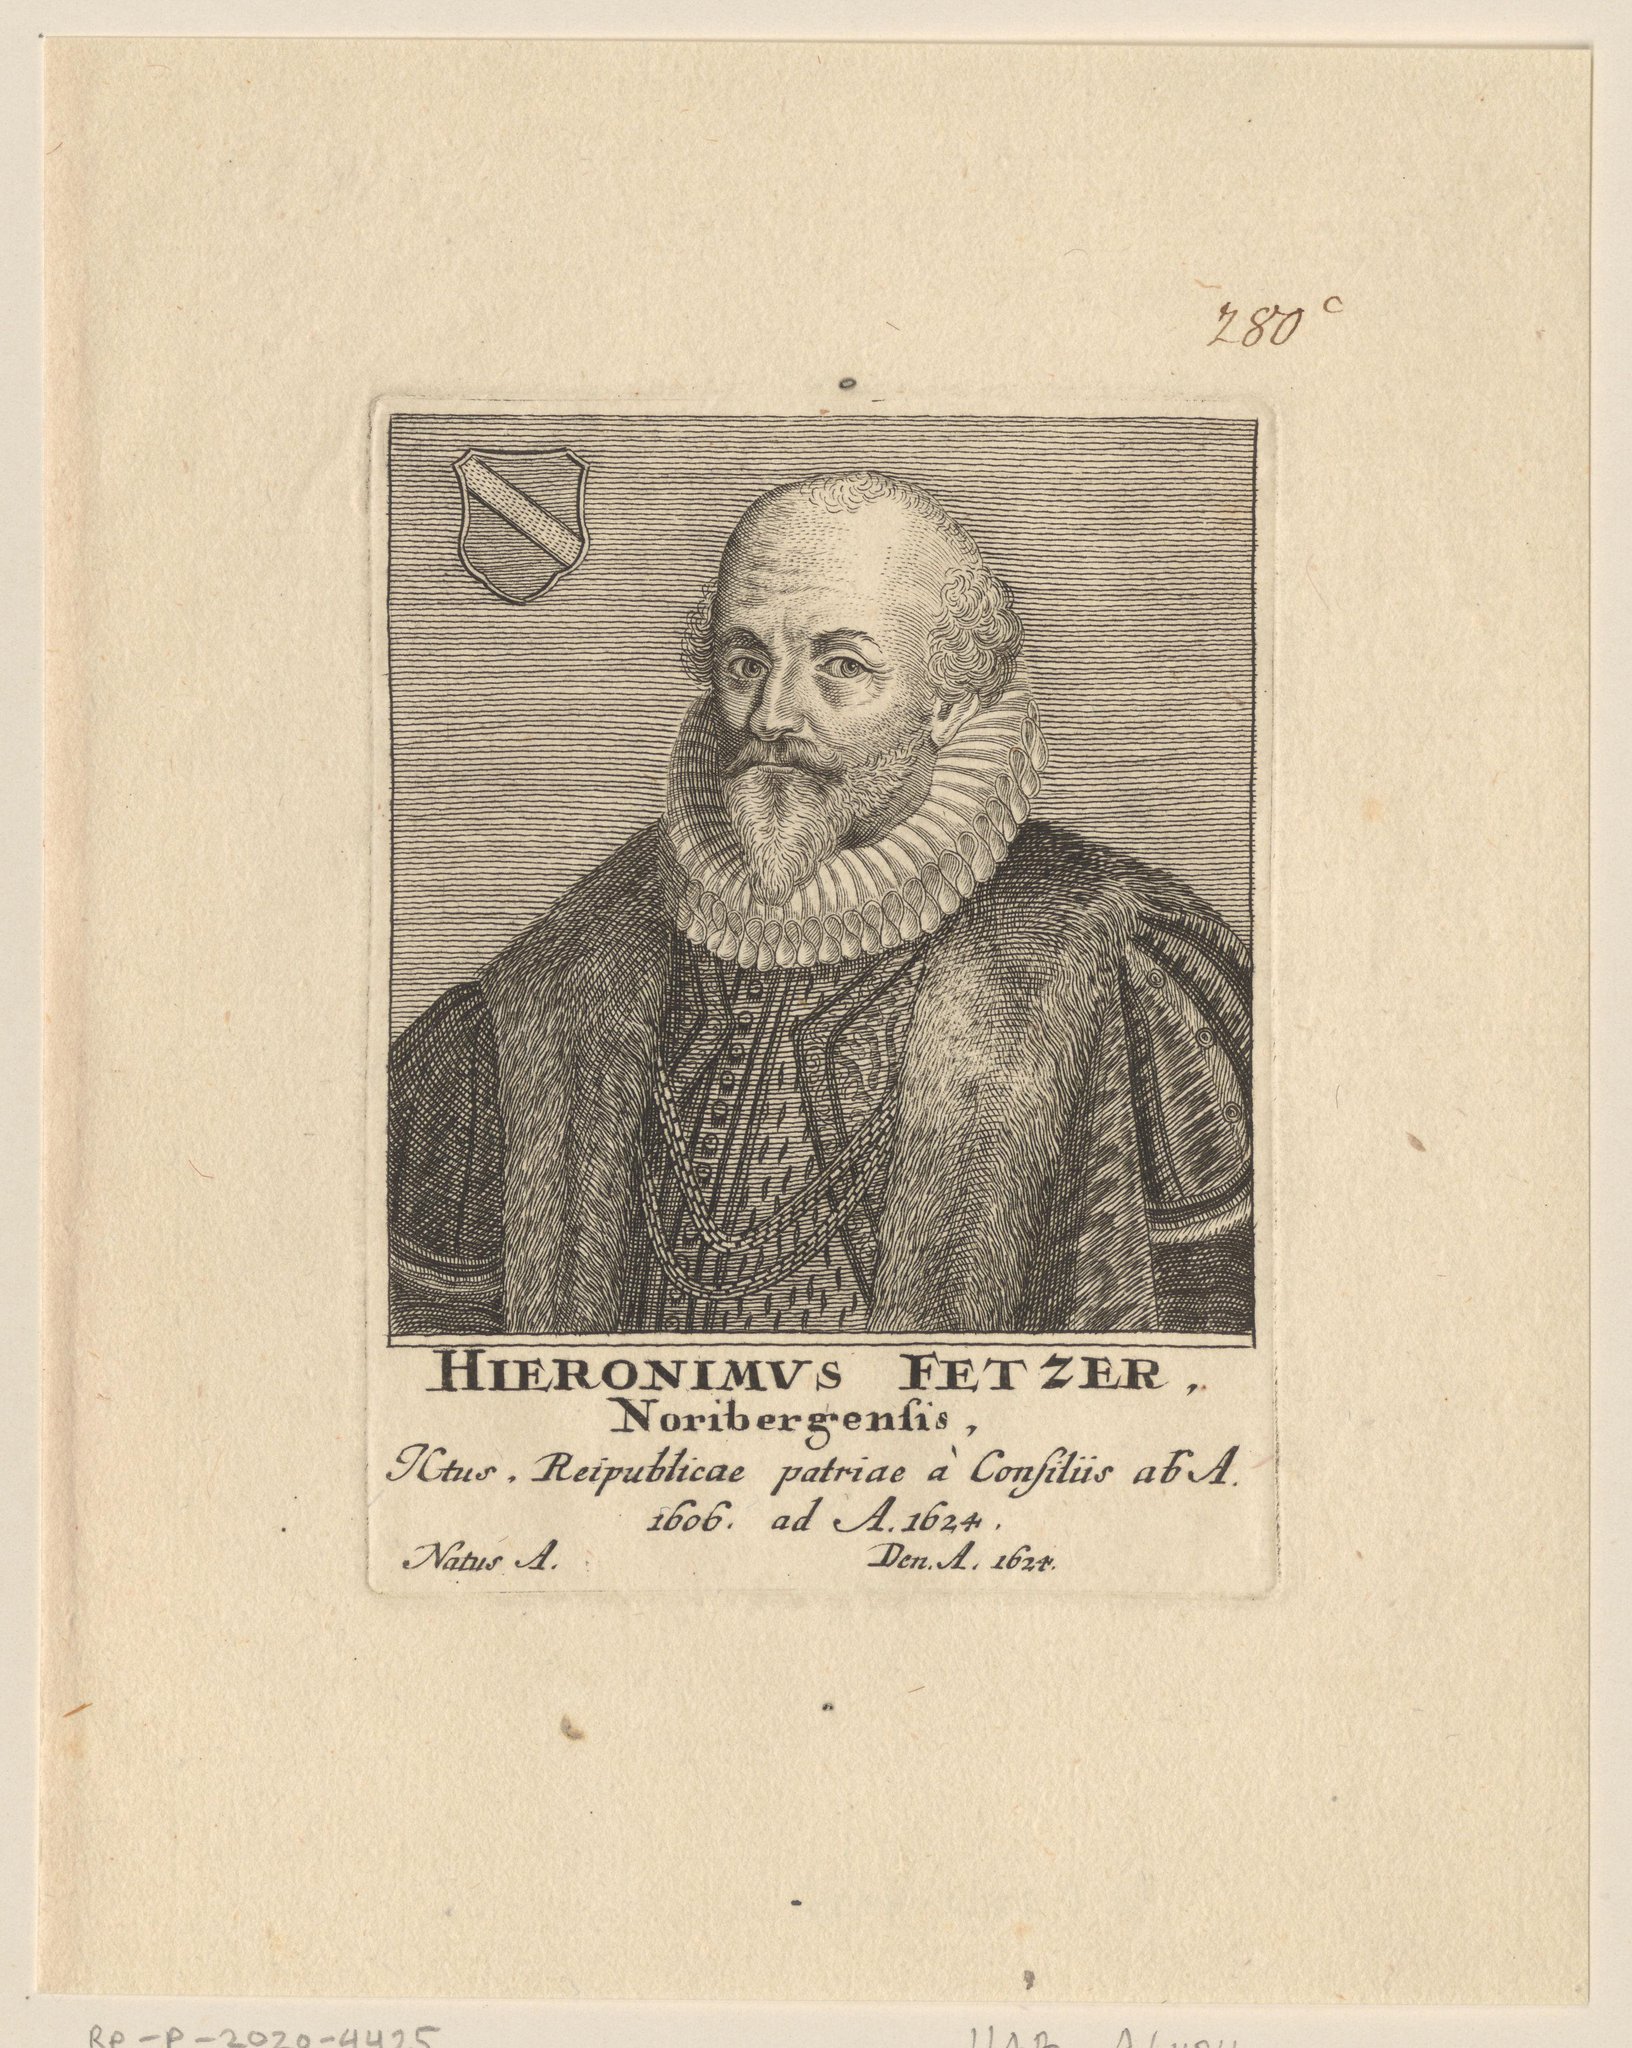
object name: book illustration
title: Portret van Hieronymus Fetzer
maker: Anonymous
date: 1725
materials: paper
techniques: engraving, etching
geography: germany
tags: historical persons, armorial bearing, heraldry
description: Prent waarschijnlijk uit: Roth-Scholtz, Friedrich. Icones virorum omnium ordinum eruditione omnique item genere (...). Neurenberg: erven Johann Daniel Tauber, 1725.